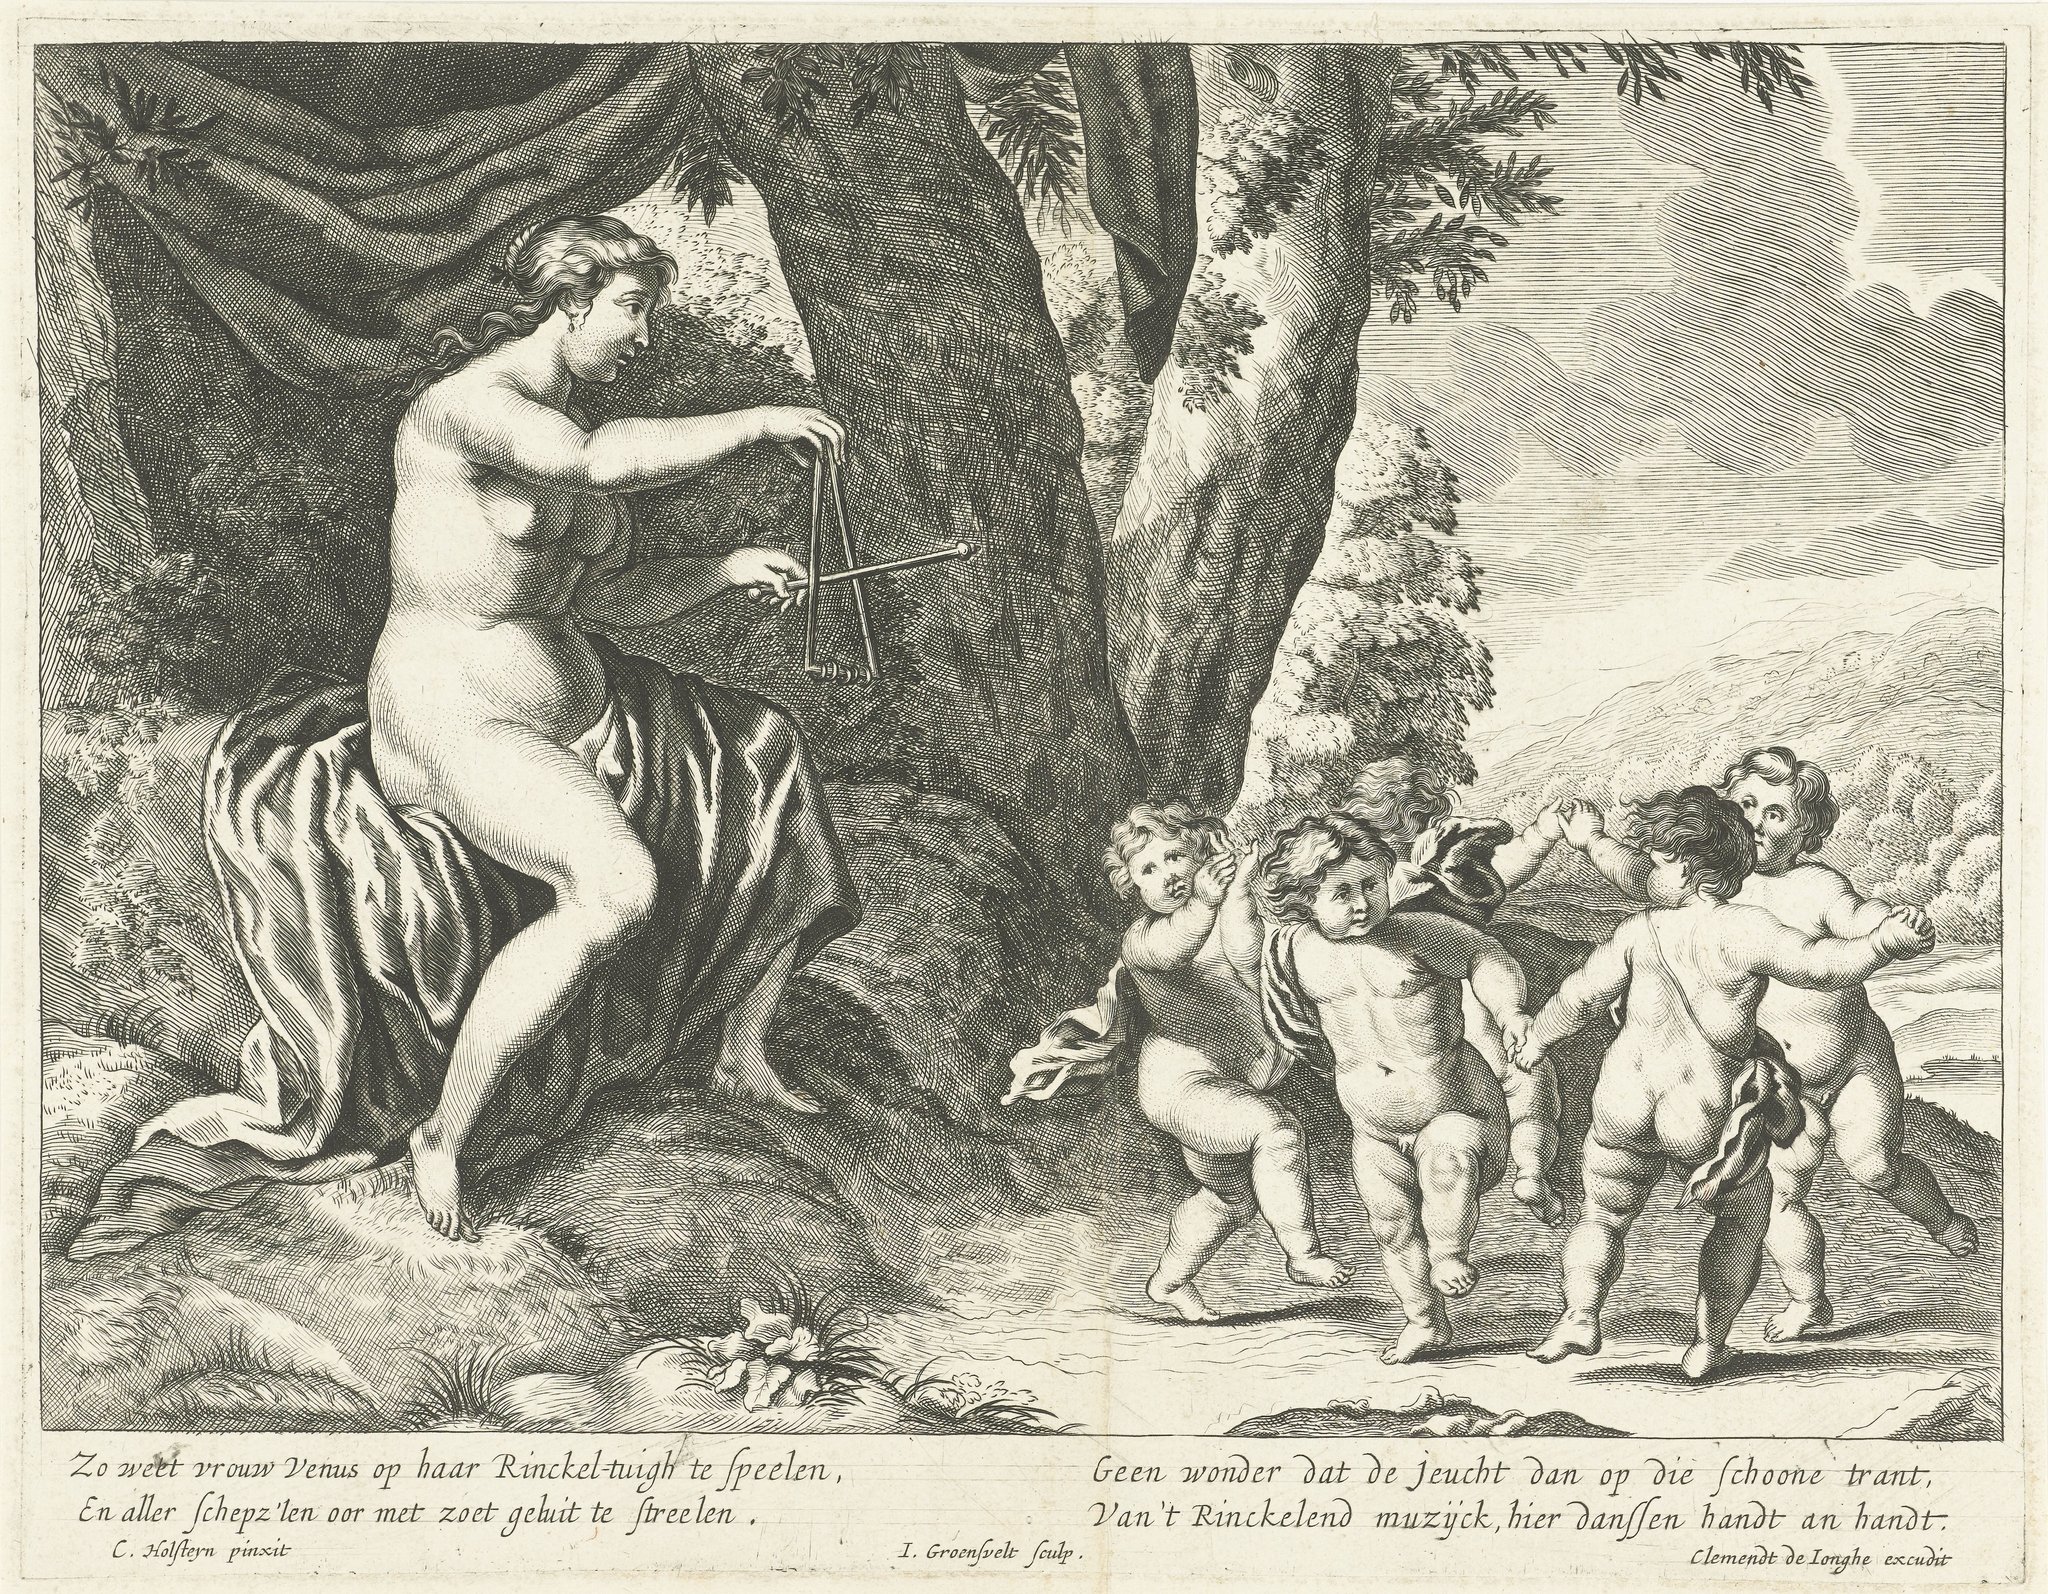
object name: print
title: Venus en dansende putti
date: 1679-1728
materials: paper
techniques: engraving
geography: amsterdam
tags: cupids: 'amores', 'amoretti', 'putti', other specific aspects of venus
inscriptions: collector's mark: Lugt 2228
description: Landschap met links Venus zittend op een rots, spelend op een triangel en rechts vijf dansende putti. In marge onder de voorstelling vierregelig gedicht in Nederlands.